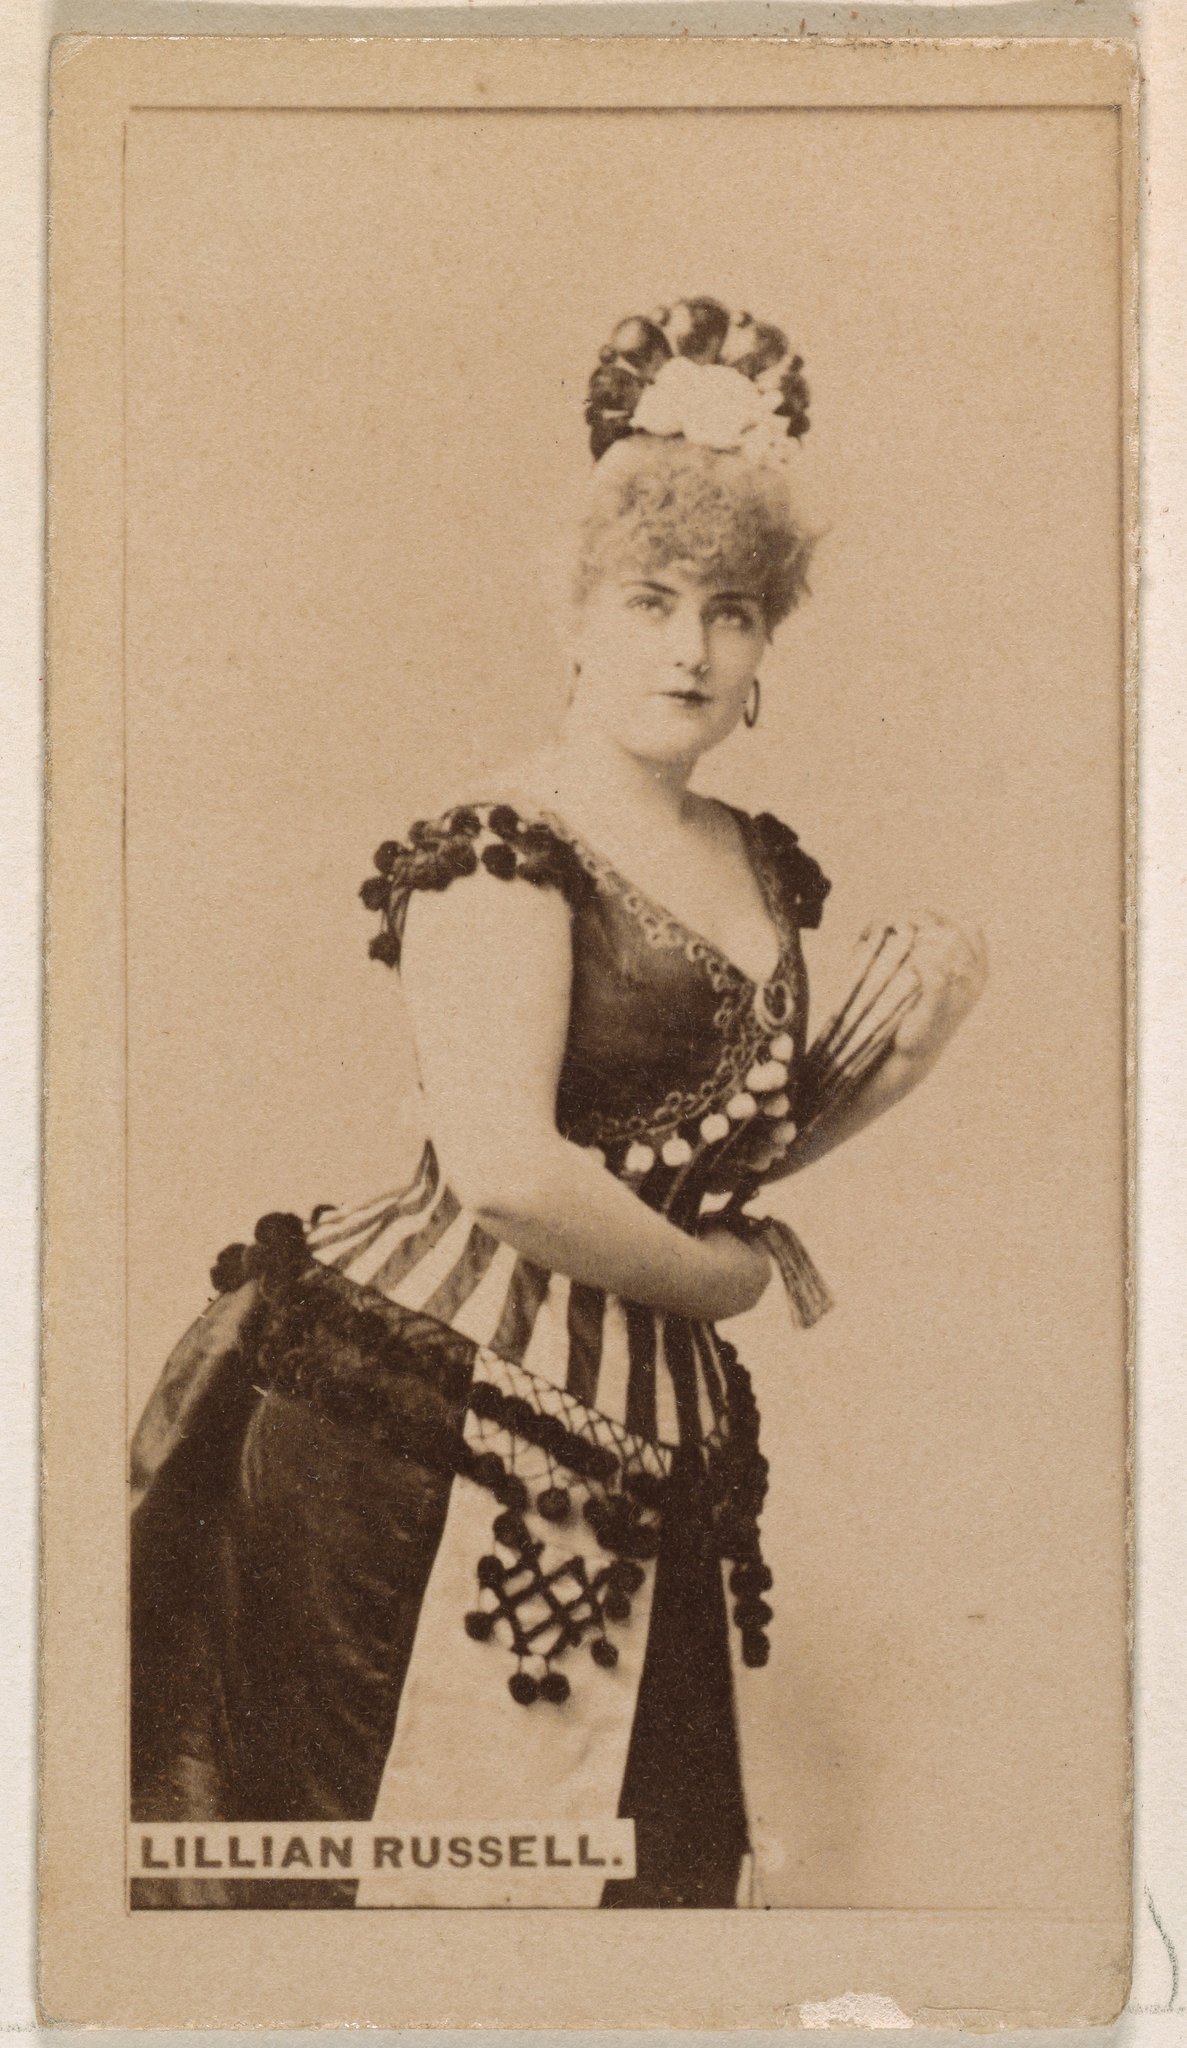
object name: photograph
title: Lillian Russell, from the Actresses series (N245) issued by Kinney Brothers to promote Sweet Caporal Cigarettes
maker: kinney brothers tobacco company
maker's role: publisher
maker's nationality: american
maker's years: 1869-2011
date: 1890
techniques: albumen silver print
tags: portraits,women,actresses